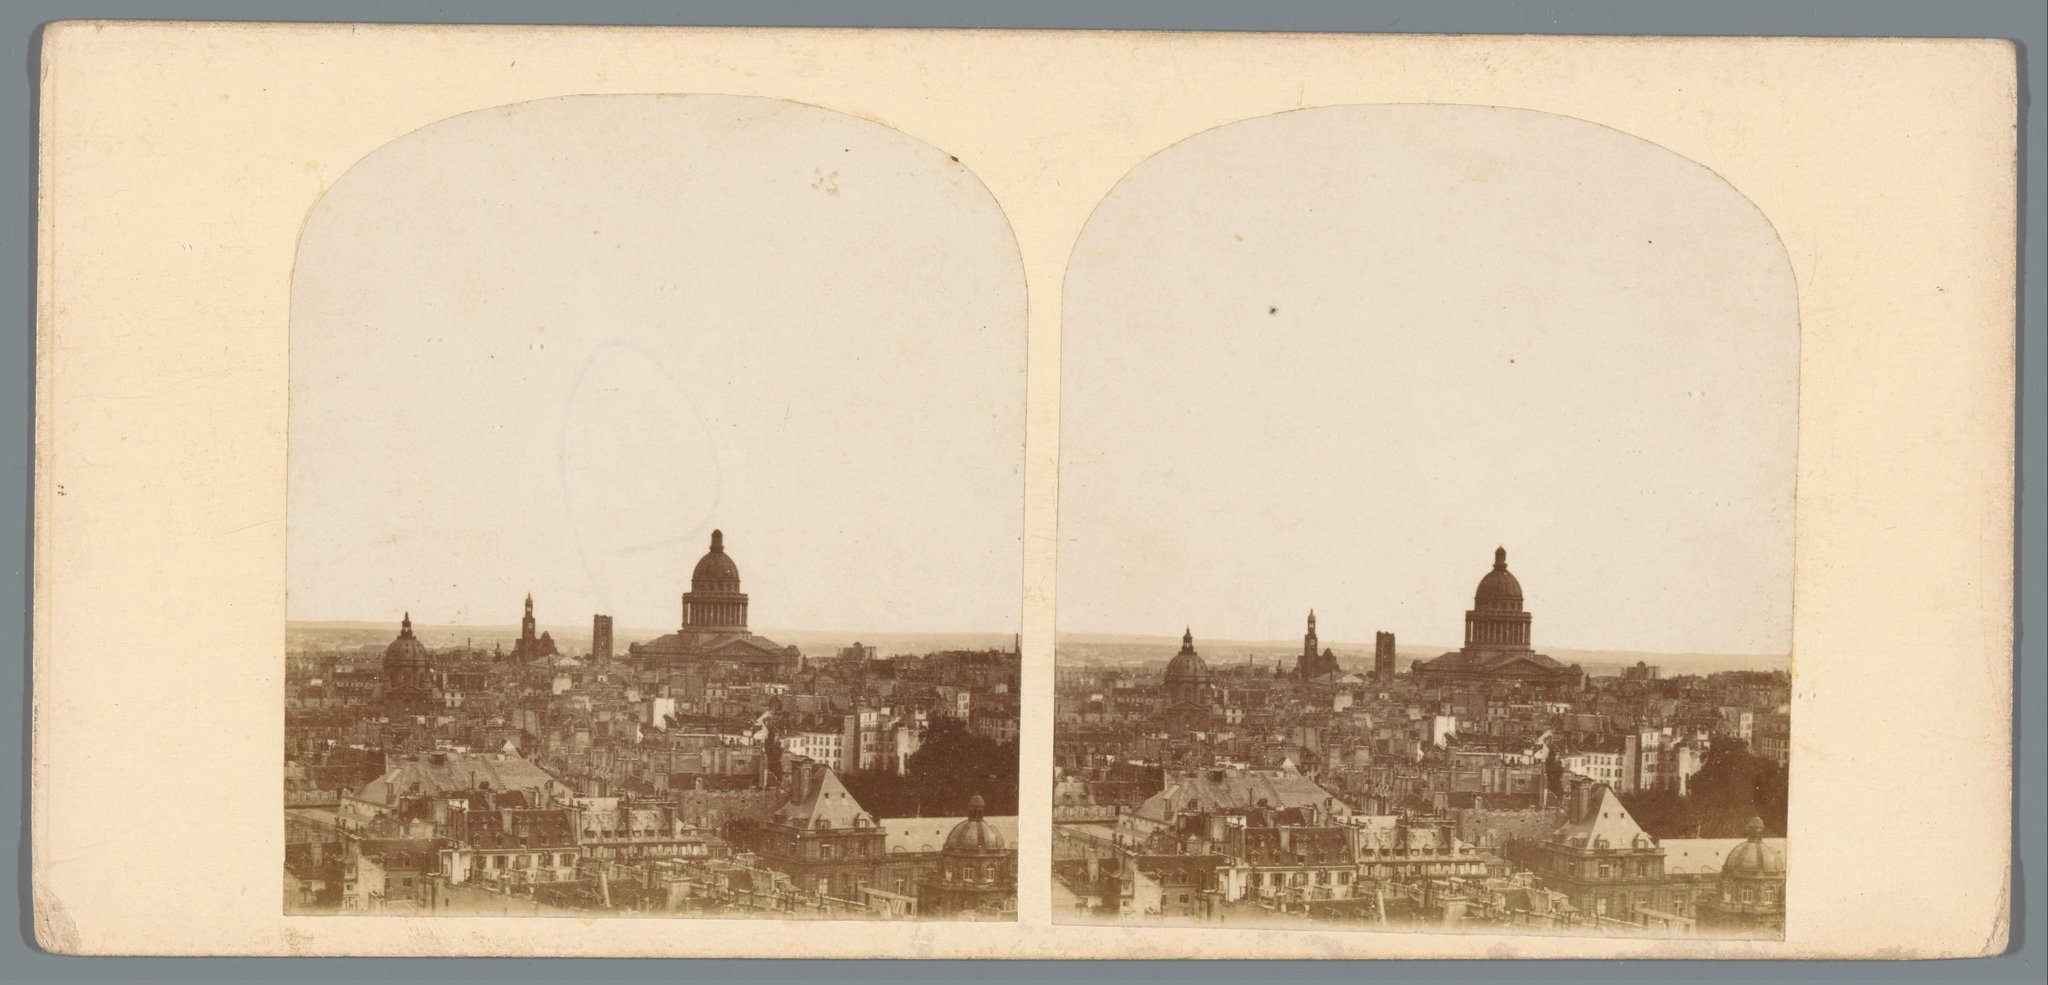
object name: stereograph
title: Panorama van Parijs met zicht op de koepel van het Panthéon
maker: Anonymous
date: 1850-1880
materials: cardboard, photographic support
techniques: albumen print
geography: paris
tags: dome ~ architecture, prospect of city, town panorama, silhouette of city, paris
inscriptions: inscription: ‘No 18. Paris, Panorama’